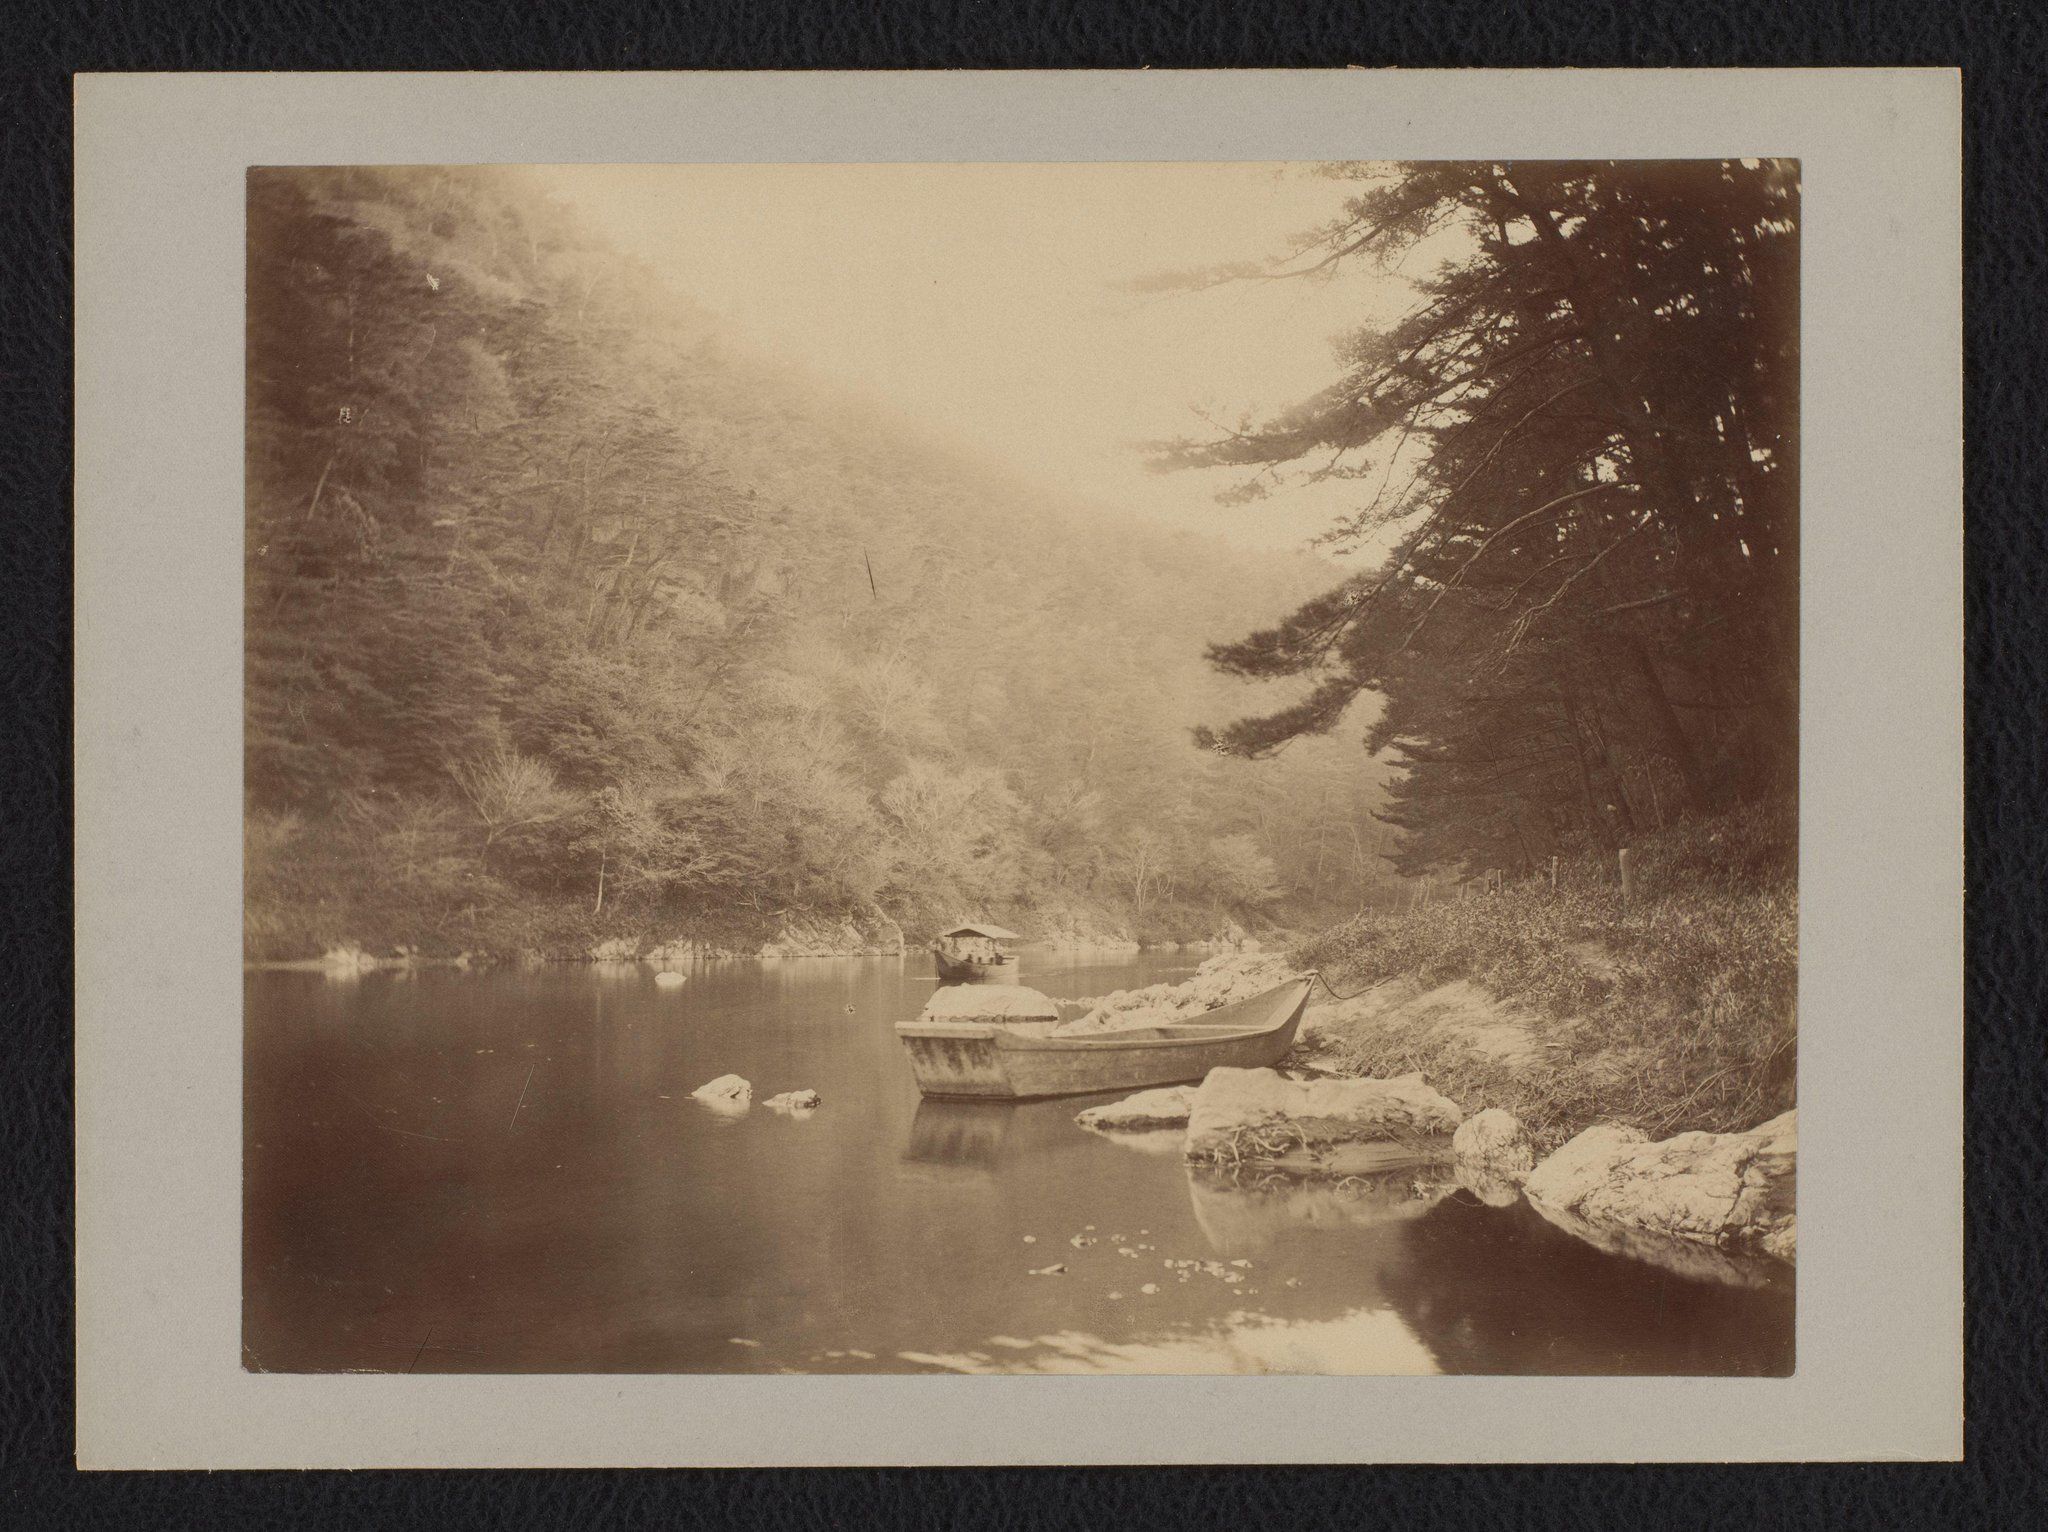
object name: photograph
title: Rivier van Hozu, Kyoto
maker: Anonymous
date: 1895-1915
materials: cardboard, photographic support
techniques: albumen print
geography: kyoto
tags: kyoto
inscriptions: annotation: ‘10. Eind der Hodzu-rapids’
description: Rechts ligt een boot aangemeerd, op de achtergrond vaart een boot met een dak.